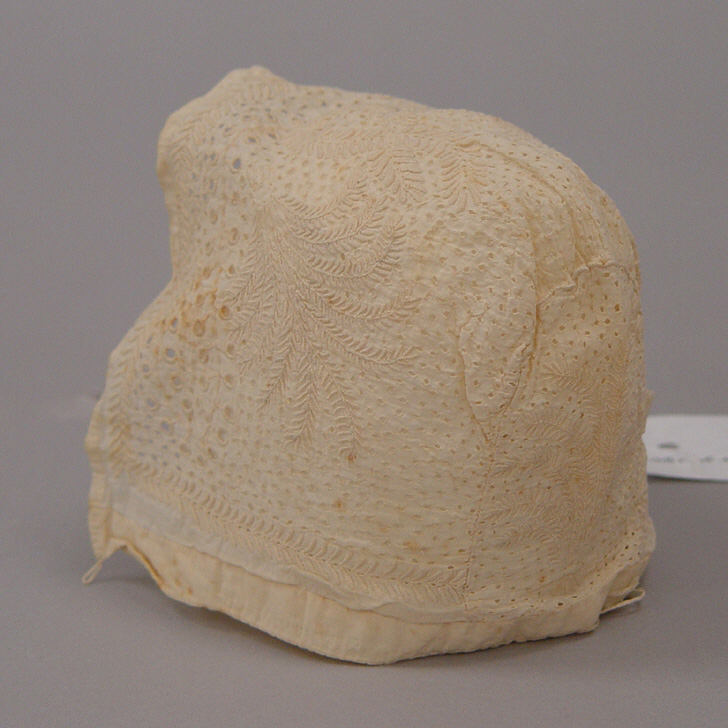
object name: cap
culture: american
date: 1800-1850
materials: cotton